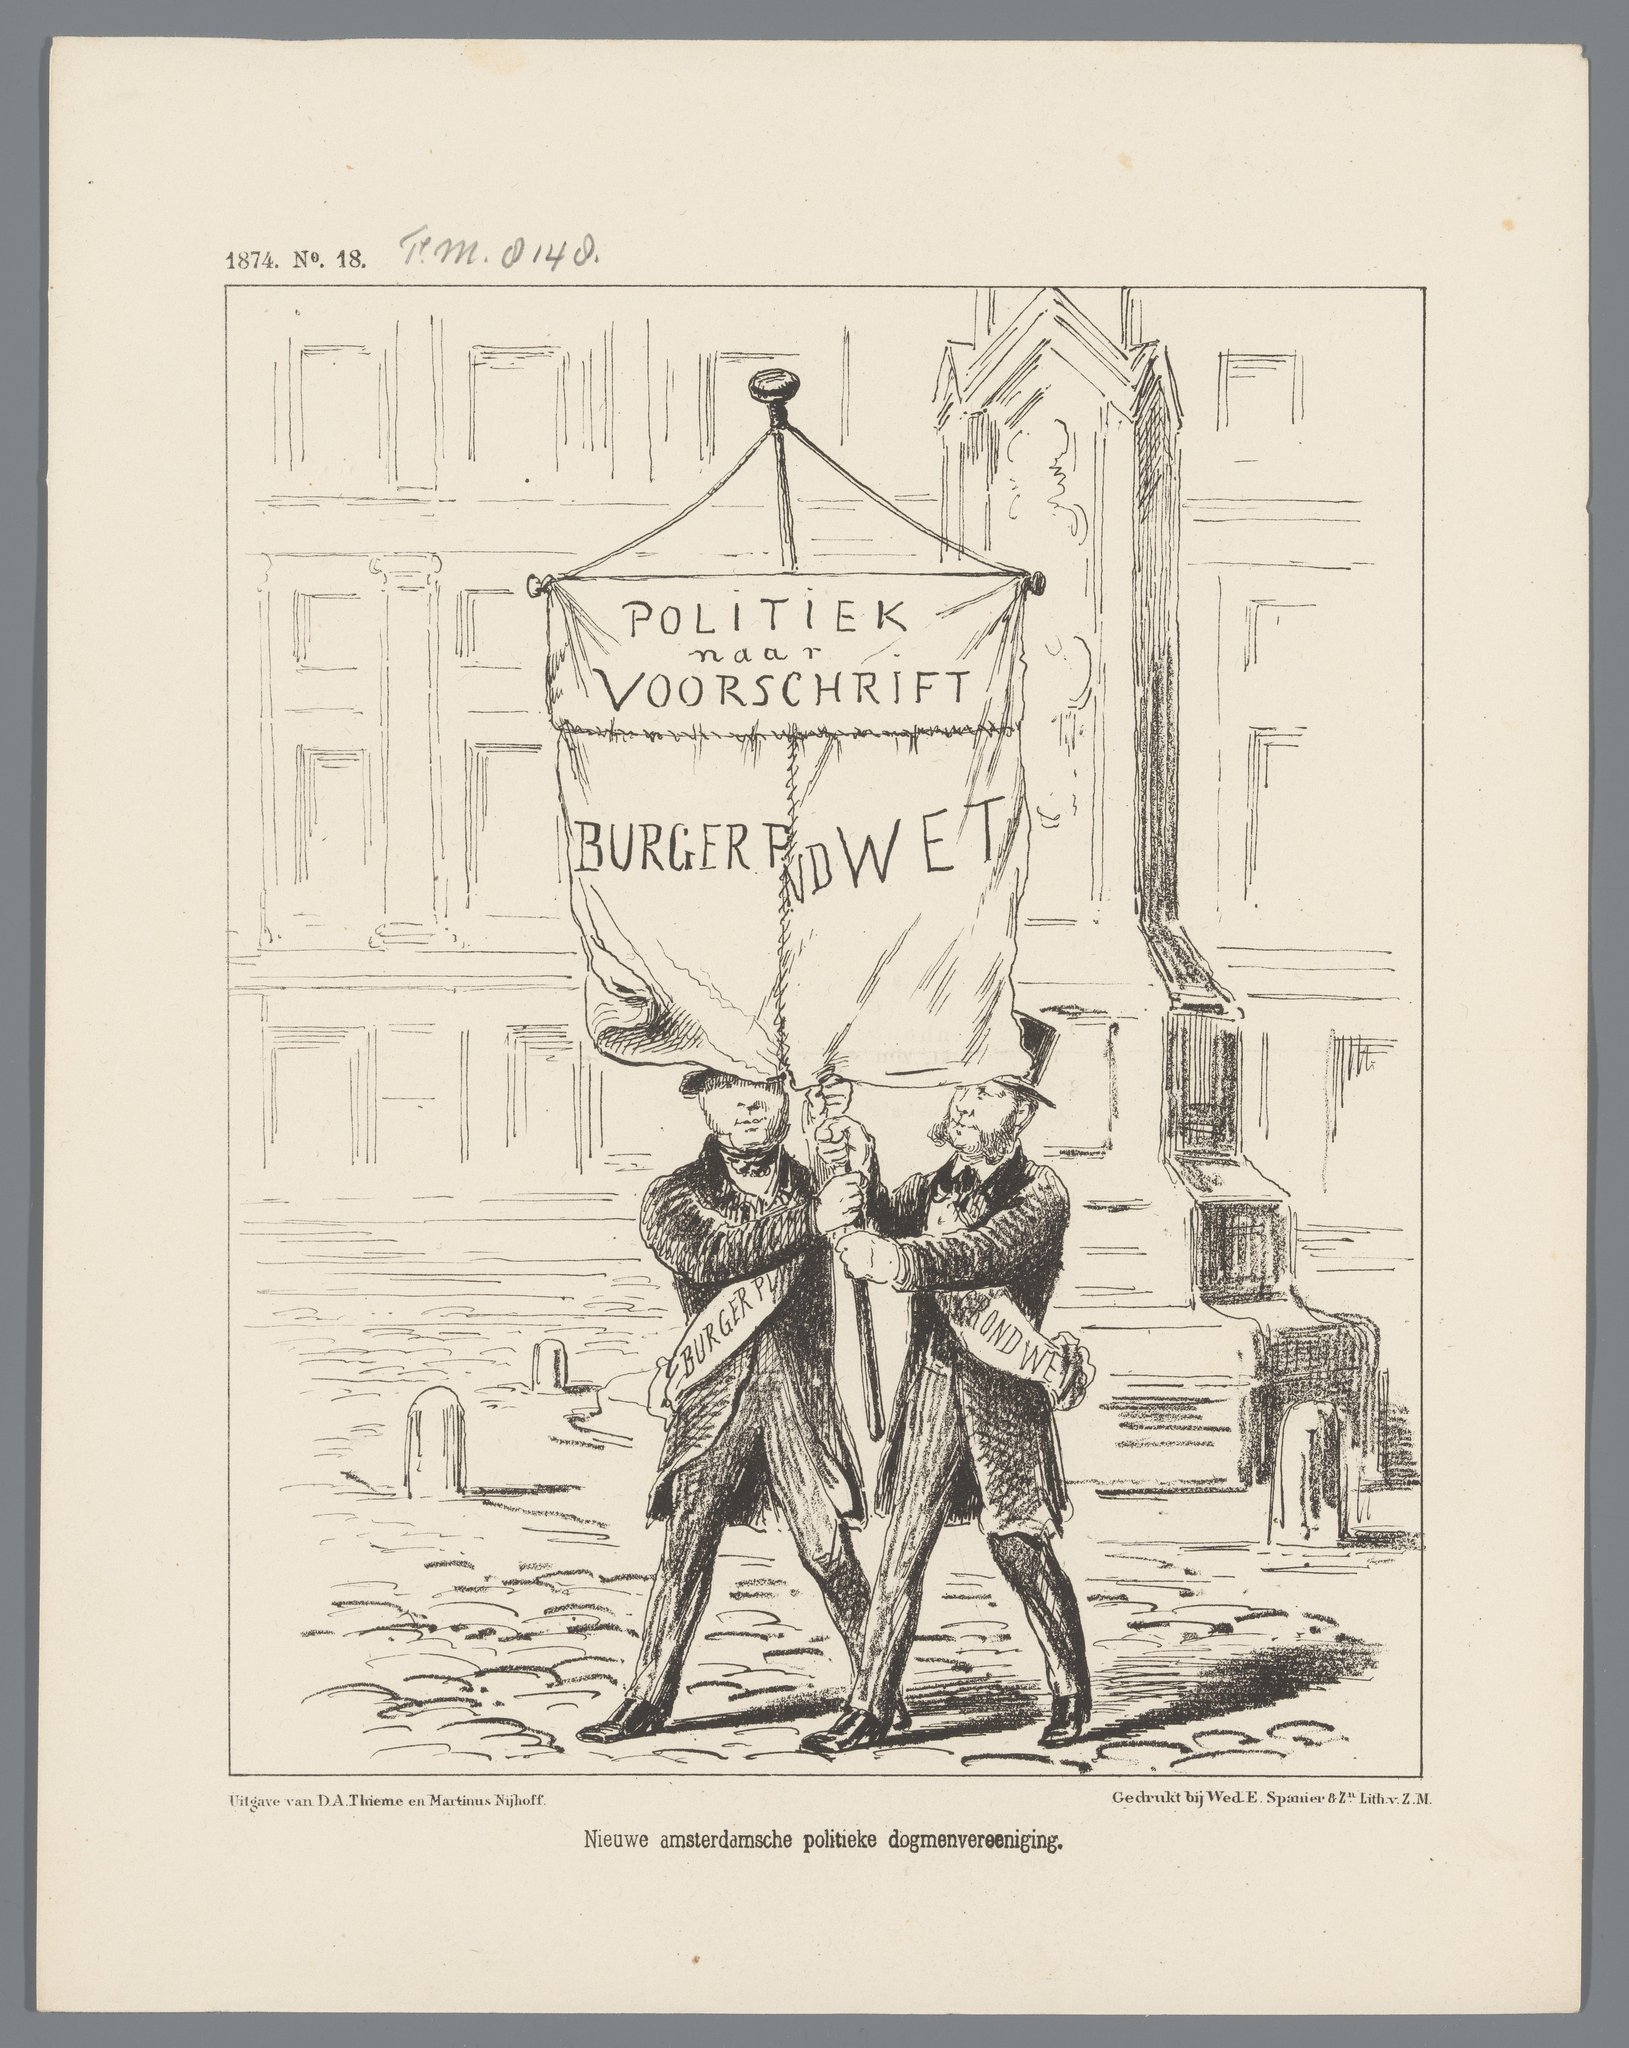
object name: print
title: Nieuwe amsterdamsche politieke dogmenvereeniging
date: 1874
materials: paper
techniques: lithograph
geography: the hague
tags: amsterdam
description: Spotprent op de Amsterdamse kieverenigingen en de vergeefse pogingen zich te verenigen, 1874. Spotprent op de. Plaat verschenen bij het weekblad De Nederlandsche Spectator, nr. 18, 1874.